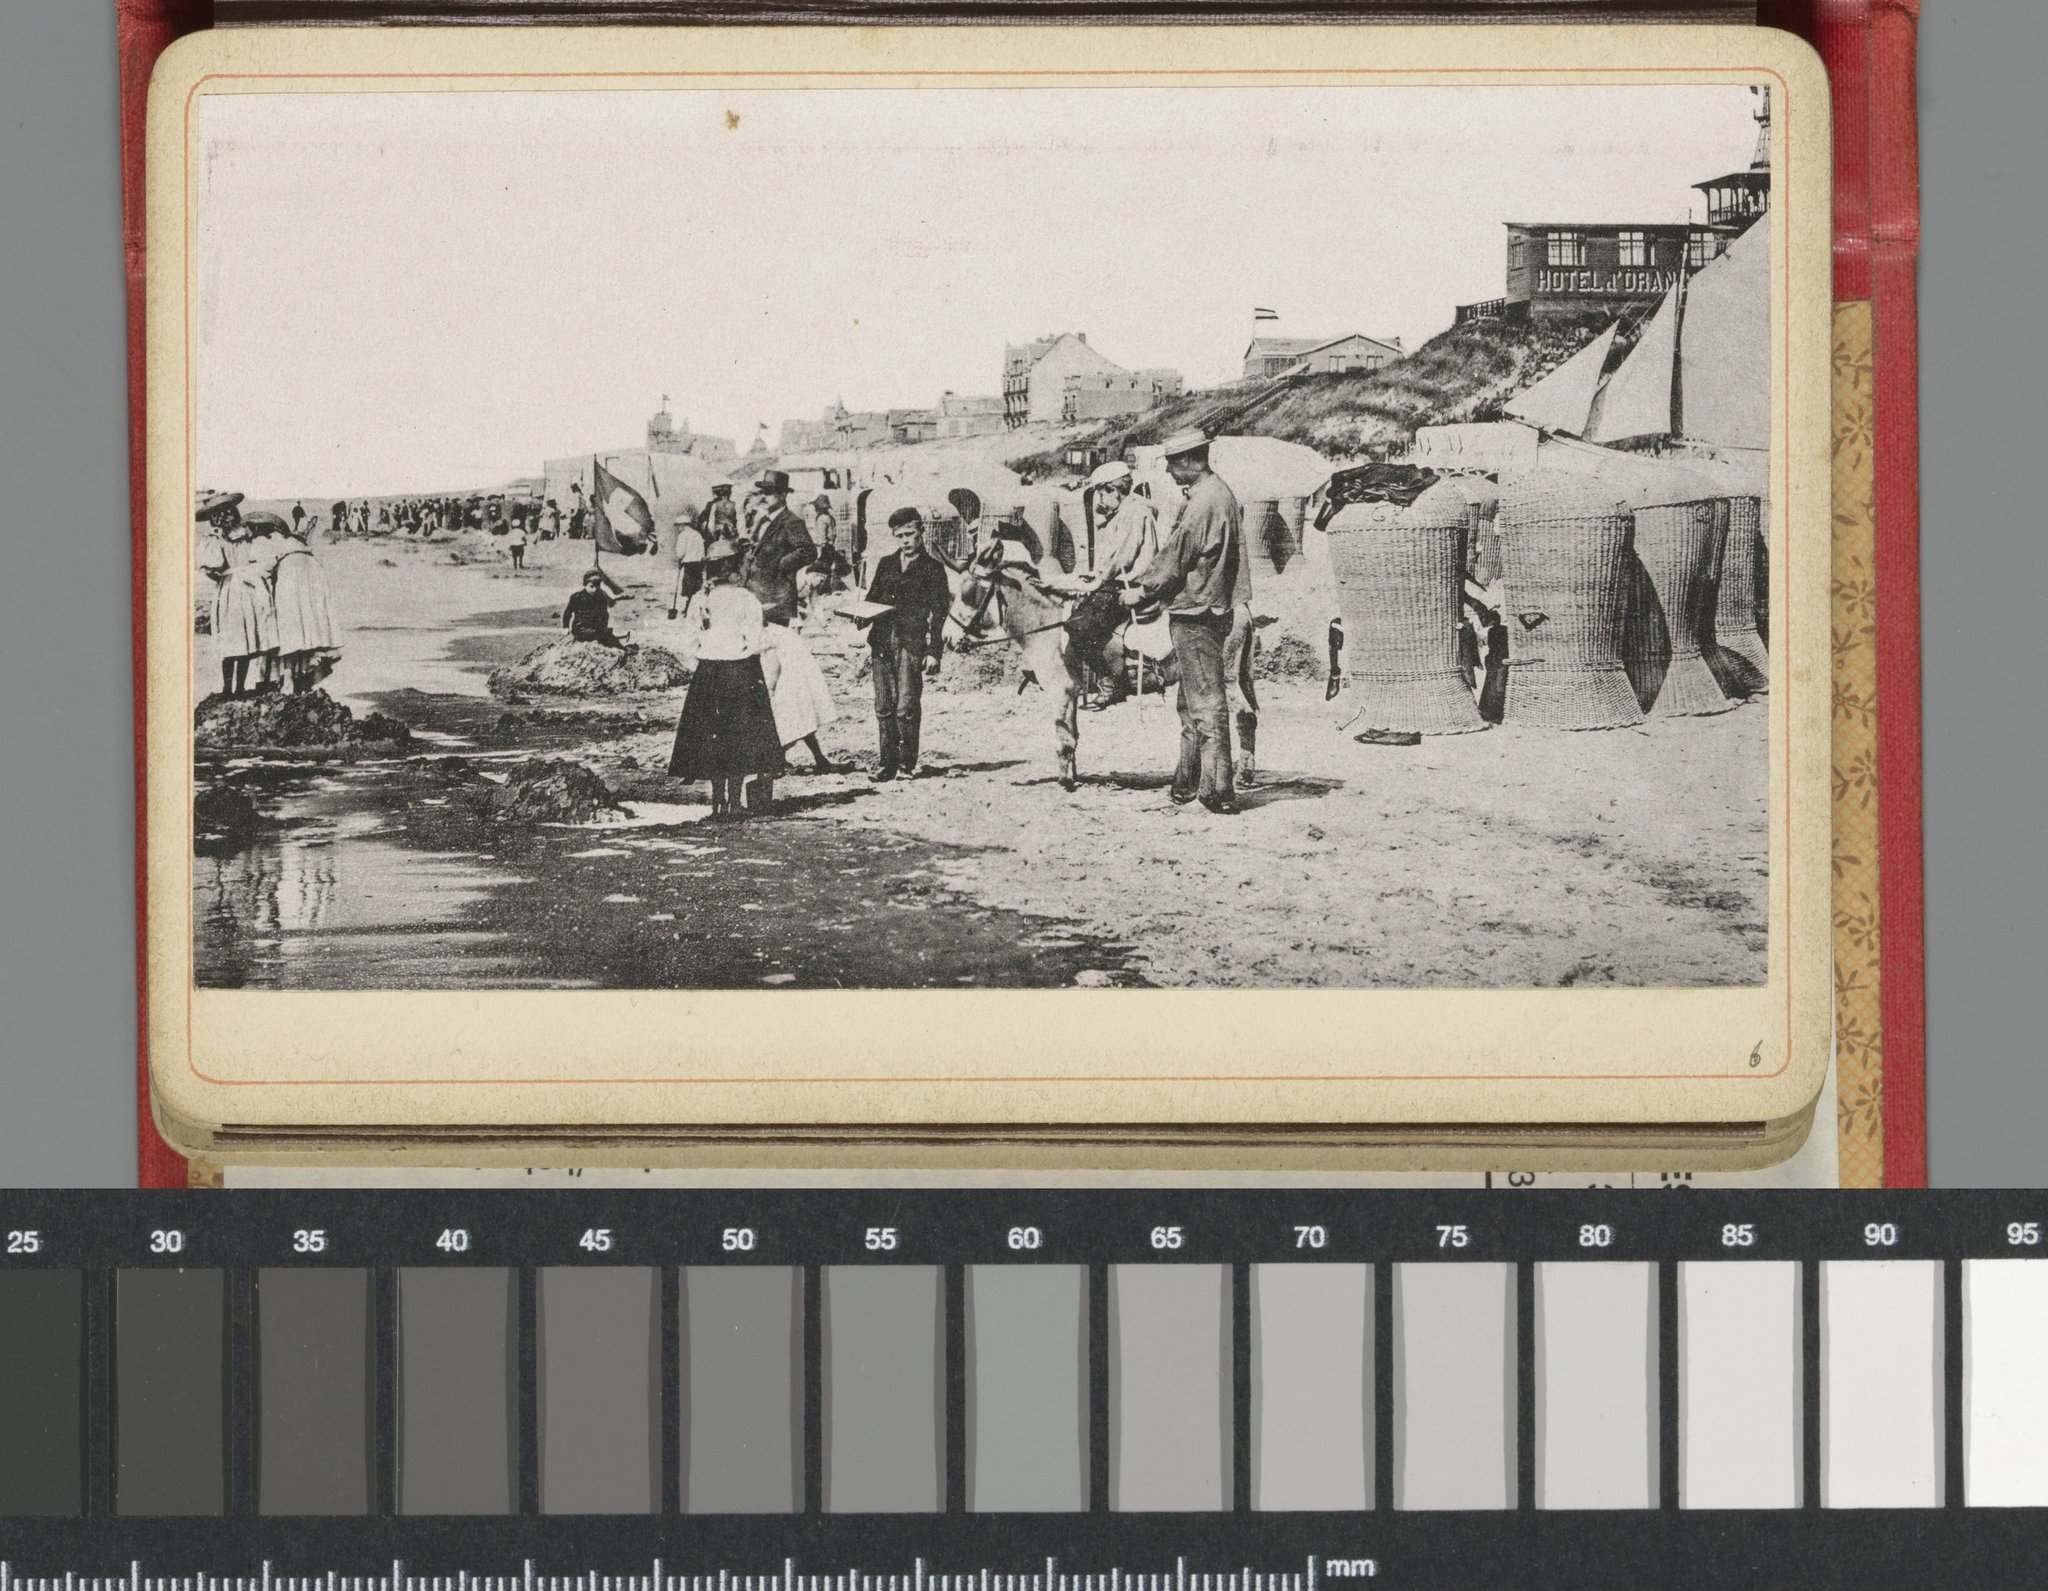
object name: photomechanical print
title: Mensen en ezel op het strand van Zandvoort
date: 1890-1900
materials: paper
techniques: photograph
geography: zandvoort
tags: beach (as place of recreation), ass, donkey, chair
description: Onderdeel van Leporelloalbum met opnames van Zandvoort.